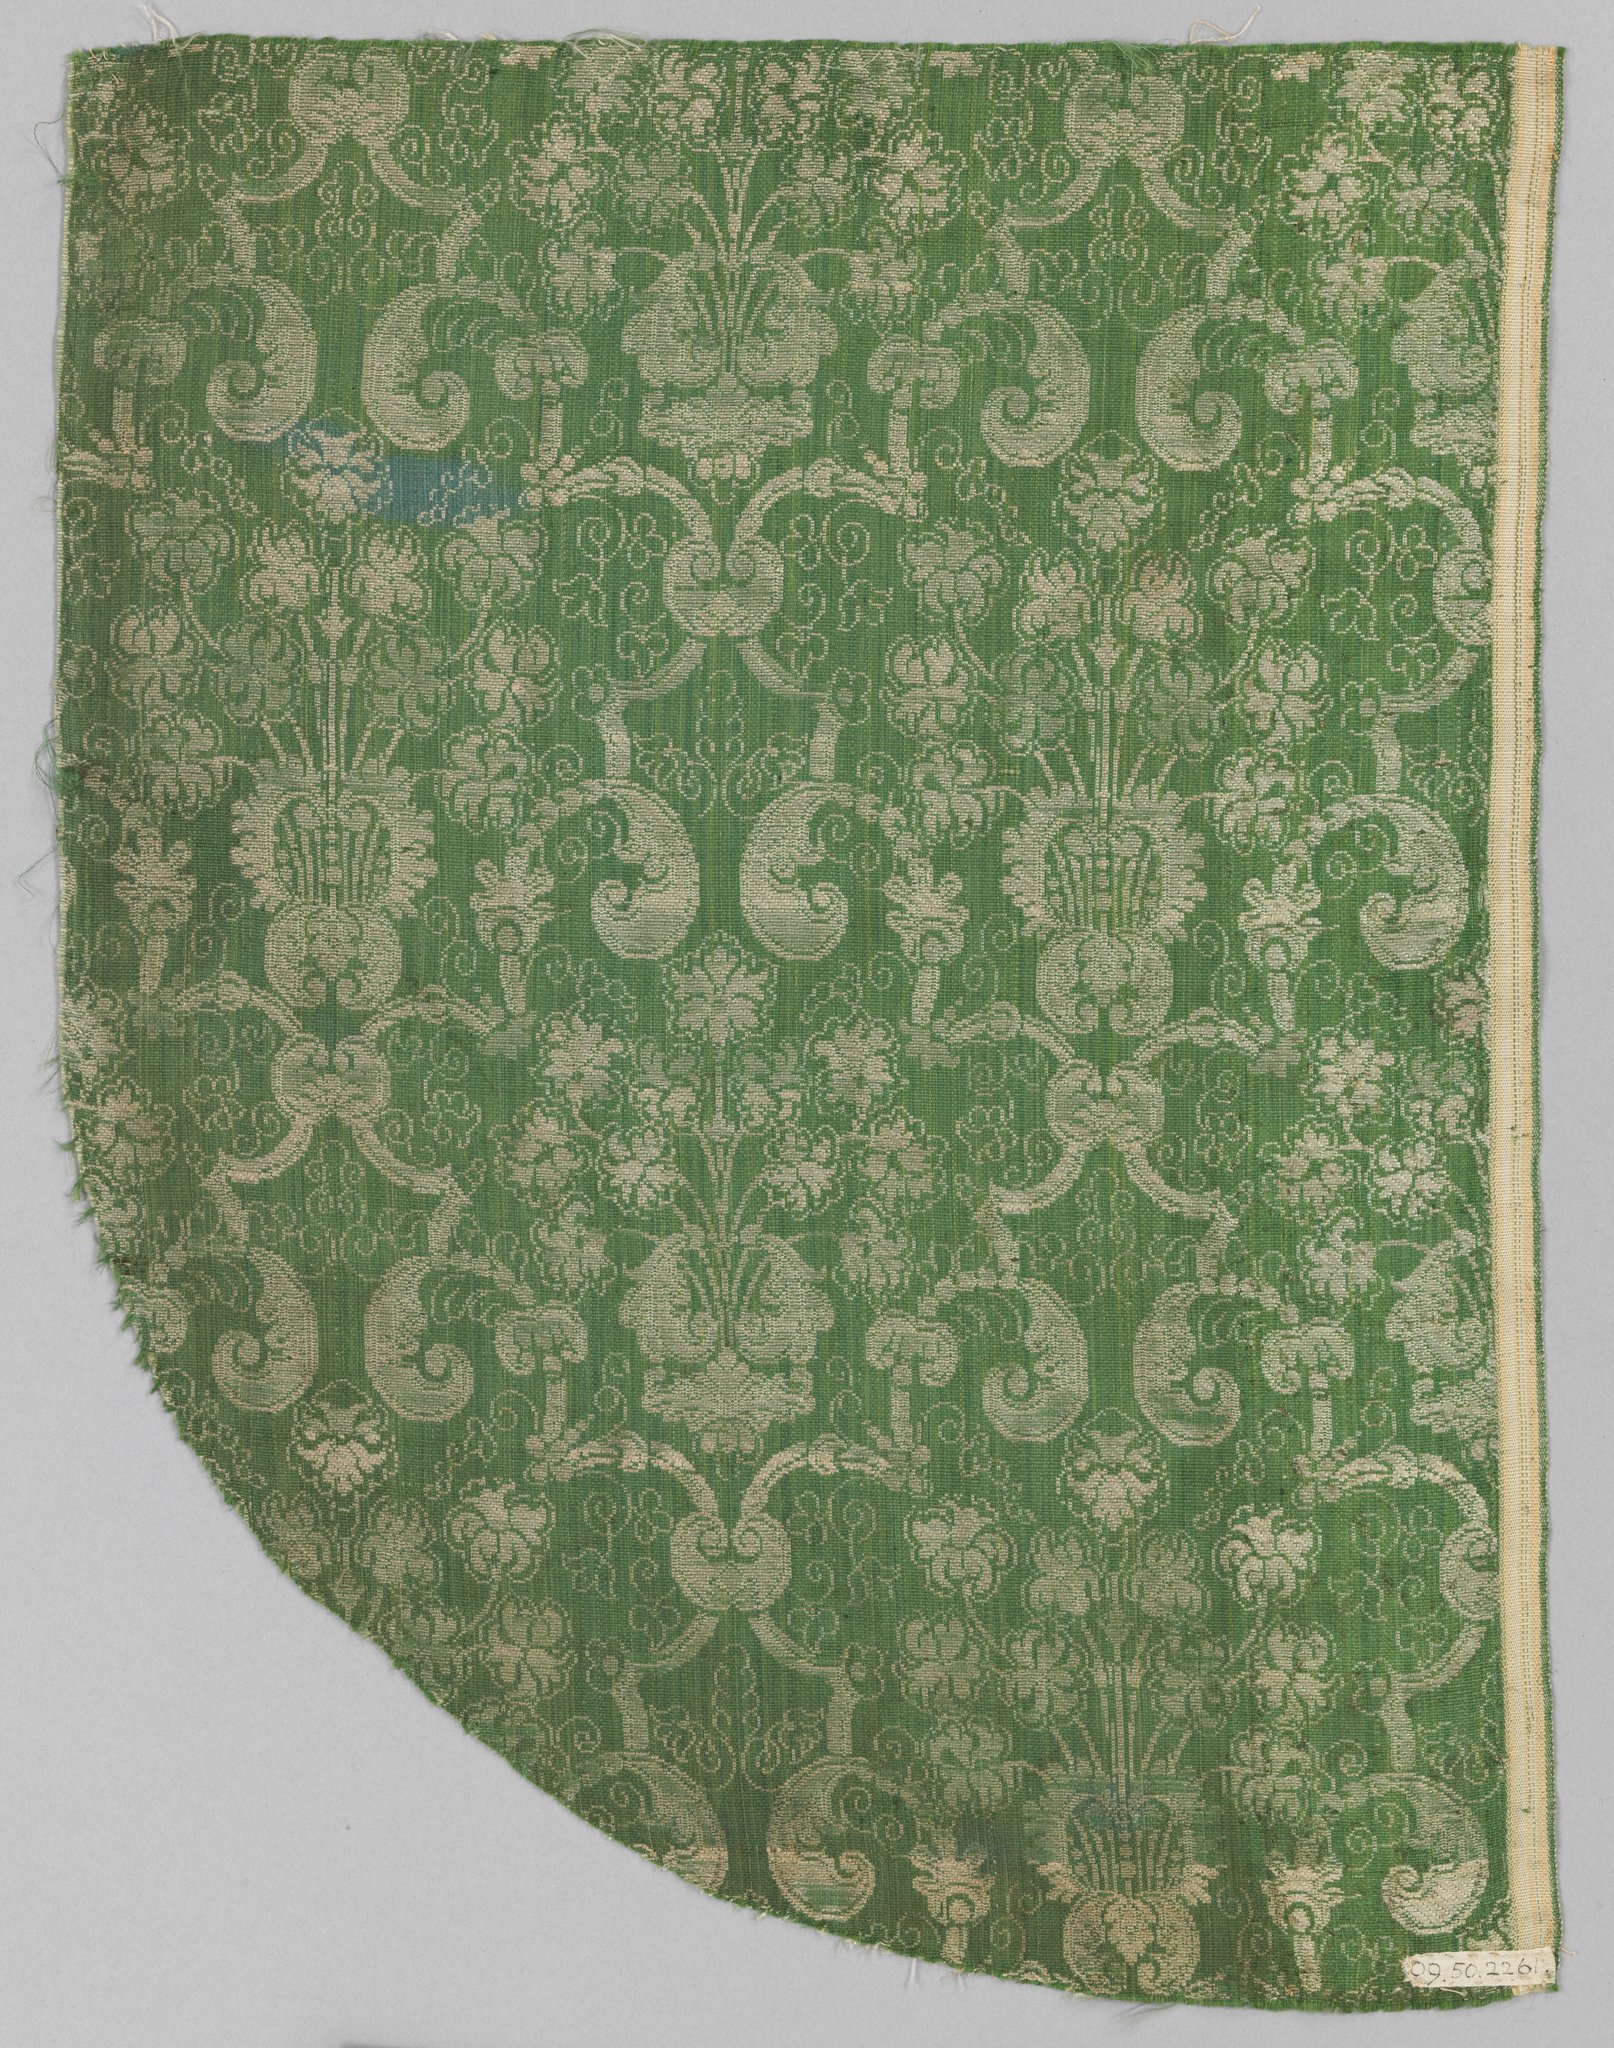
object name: piece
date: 1801-1900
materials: silk